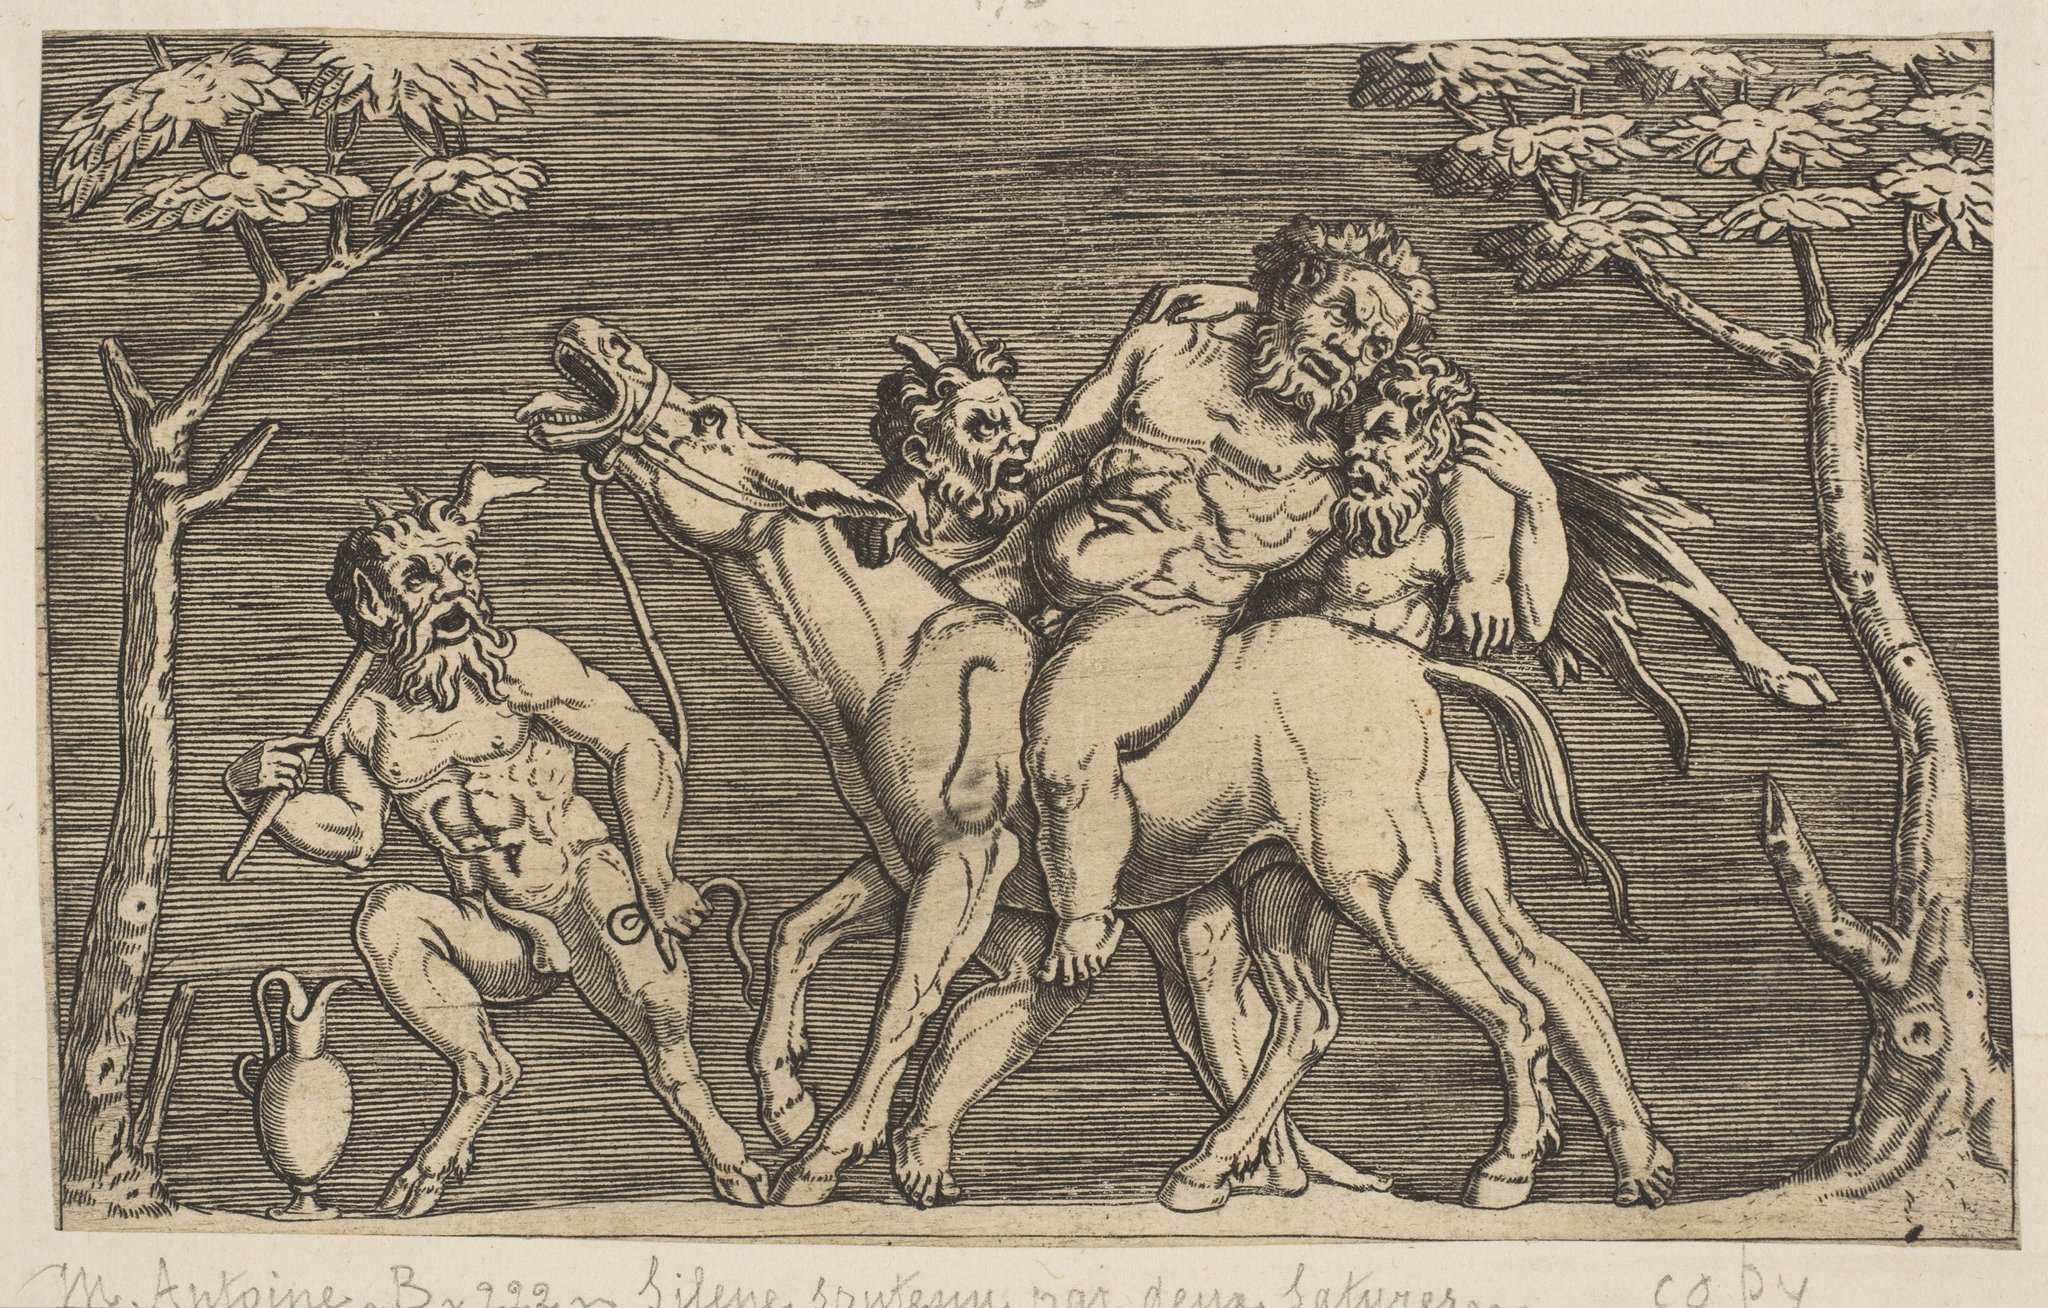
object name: print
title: Two satyrs placing Silenus on a braying mule and a third satyr at left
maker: anonymous, italian, 16th to early 17th century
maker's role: artist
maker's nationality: italian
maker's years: 1500-1640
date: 1515-1600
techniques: engraving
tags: silenus,satyrs,donkeys